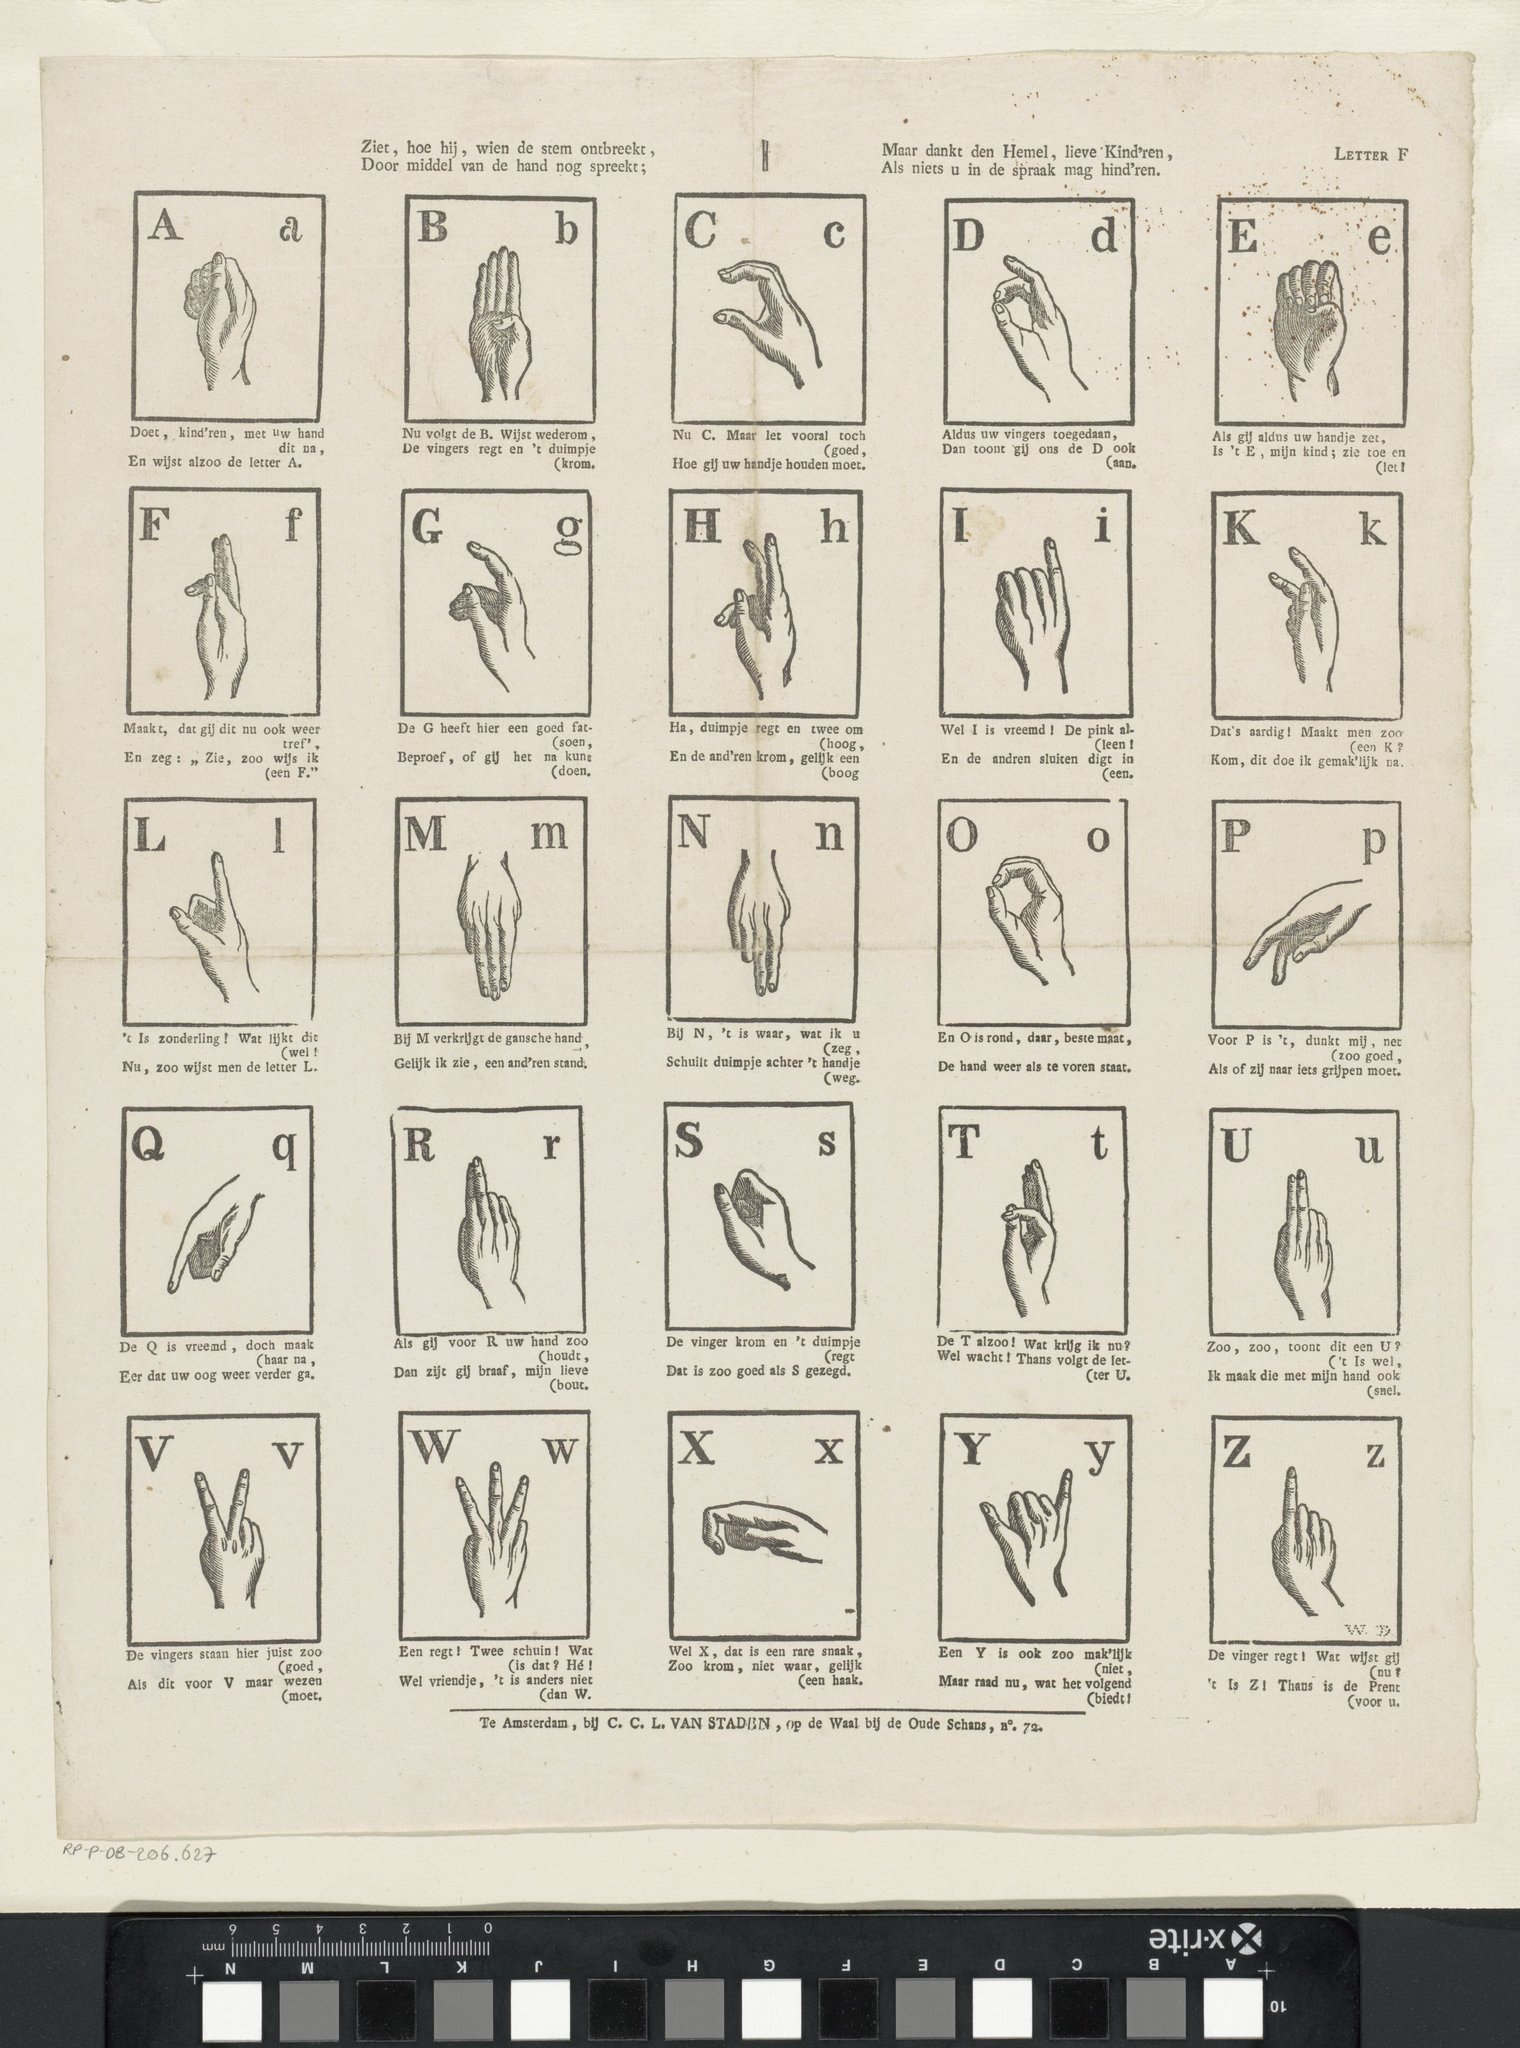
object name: print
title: Ziet, hoe hij, wien de stem ontbreekt, / Door middel van de hand nog spreekt; / Maar dankt den hemel, lieve kind'ren, / Als niets u in de spraak mag hind'ren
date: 1822-1870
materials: paper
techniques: letterpress printing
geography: netherlands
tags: letters, alphabet, script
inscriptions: collector's mark: Lugt 2760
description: Blad met 25 voorstellingen van de letters van het alfabet geïllustreerd met handengebaren waarmee alle letters van een alfabet worden uitgebeeld (handalfabet). Onder elke voorstelling een tweeregelig vers. Rechtsboven gemerkt: Letter F.